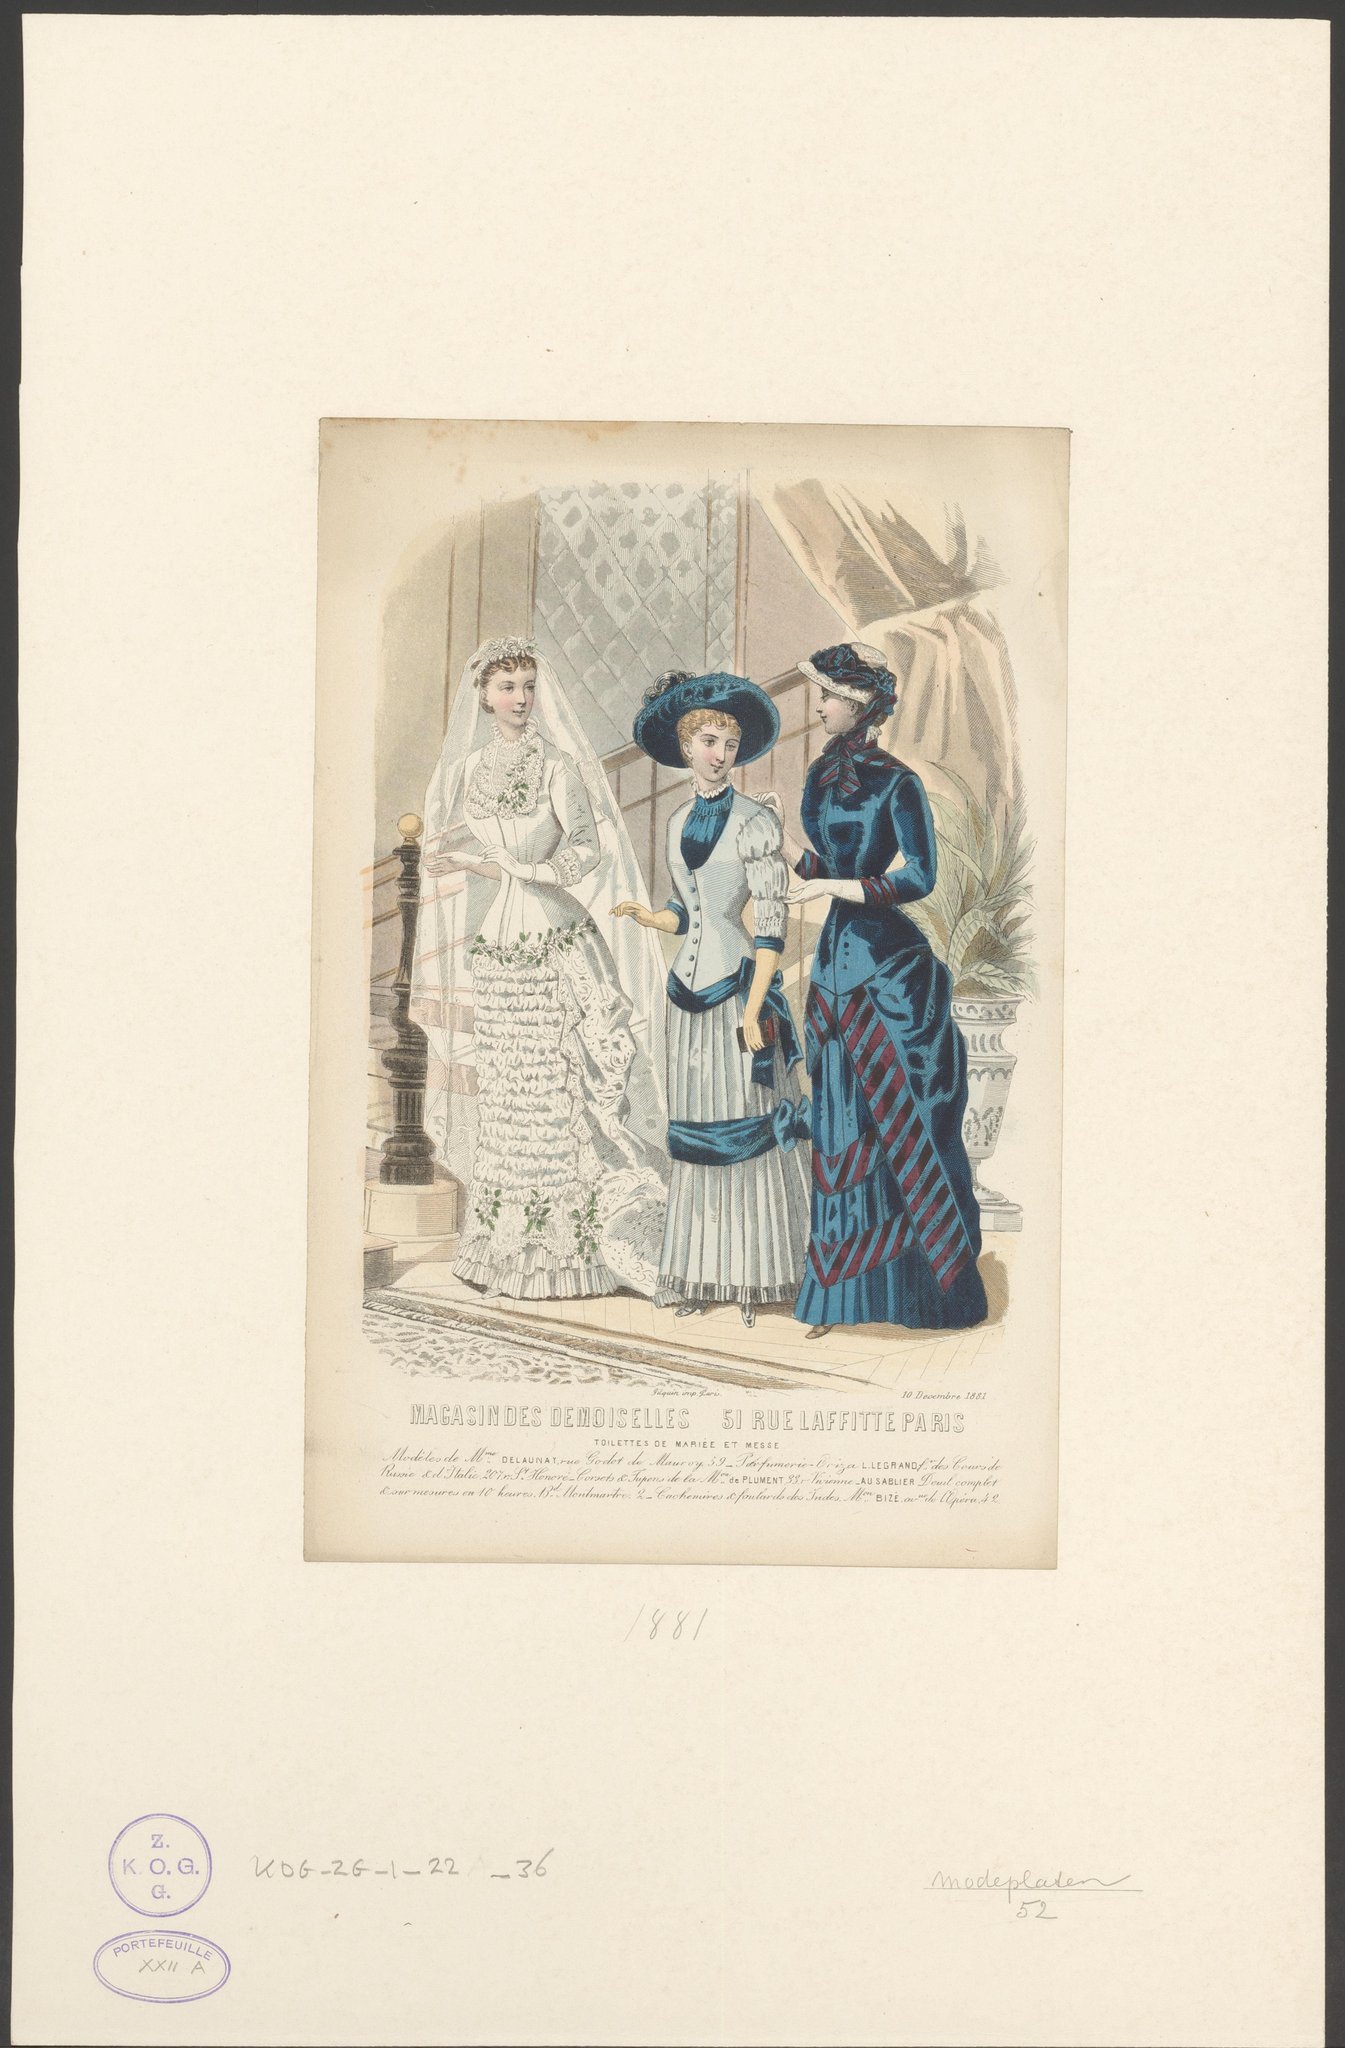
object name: print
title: Vrouw in bruidsjurk met andere vrouw en meisje gekleed voor de kerk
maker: Anonymous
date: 1881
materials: paper, watercolor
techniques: etching, hand coloring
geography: paris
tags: fashion plates, clothes, costume (+ women's clothes), dress, gown (+ women's clothes), bride (in wedding-dress)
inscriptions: collector's mark: Lugt 1641, collector's mark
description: Een vrouw in bruidsjurk en een andere vrouw en een meisje gekleed voor de kerk. Onder de voorstelling volgen enkele regels reclametekst voor verschillende producten. Prent uit het modetijdschrift Magasin des Demoiselles (1844-1896). Onderwerpsrubrieken binnen de Atlas Zeden en Gewoonten: De Kleeding, Modeplaten.